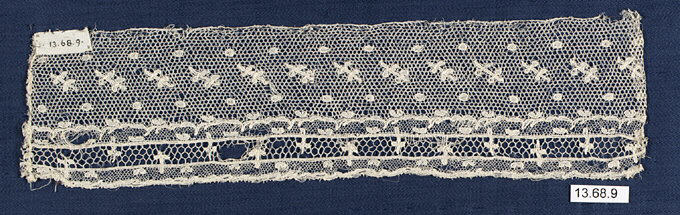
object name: fragment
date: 1801-1833